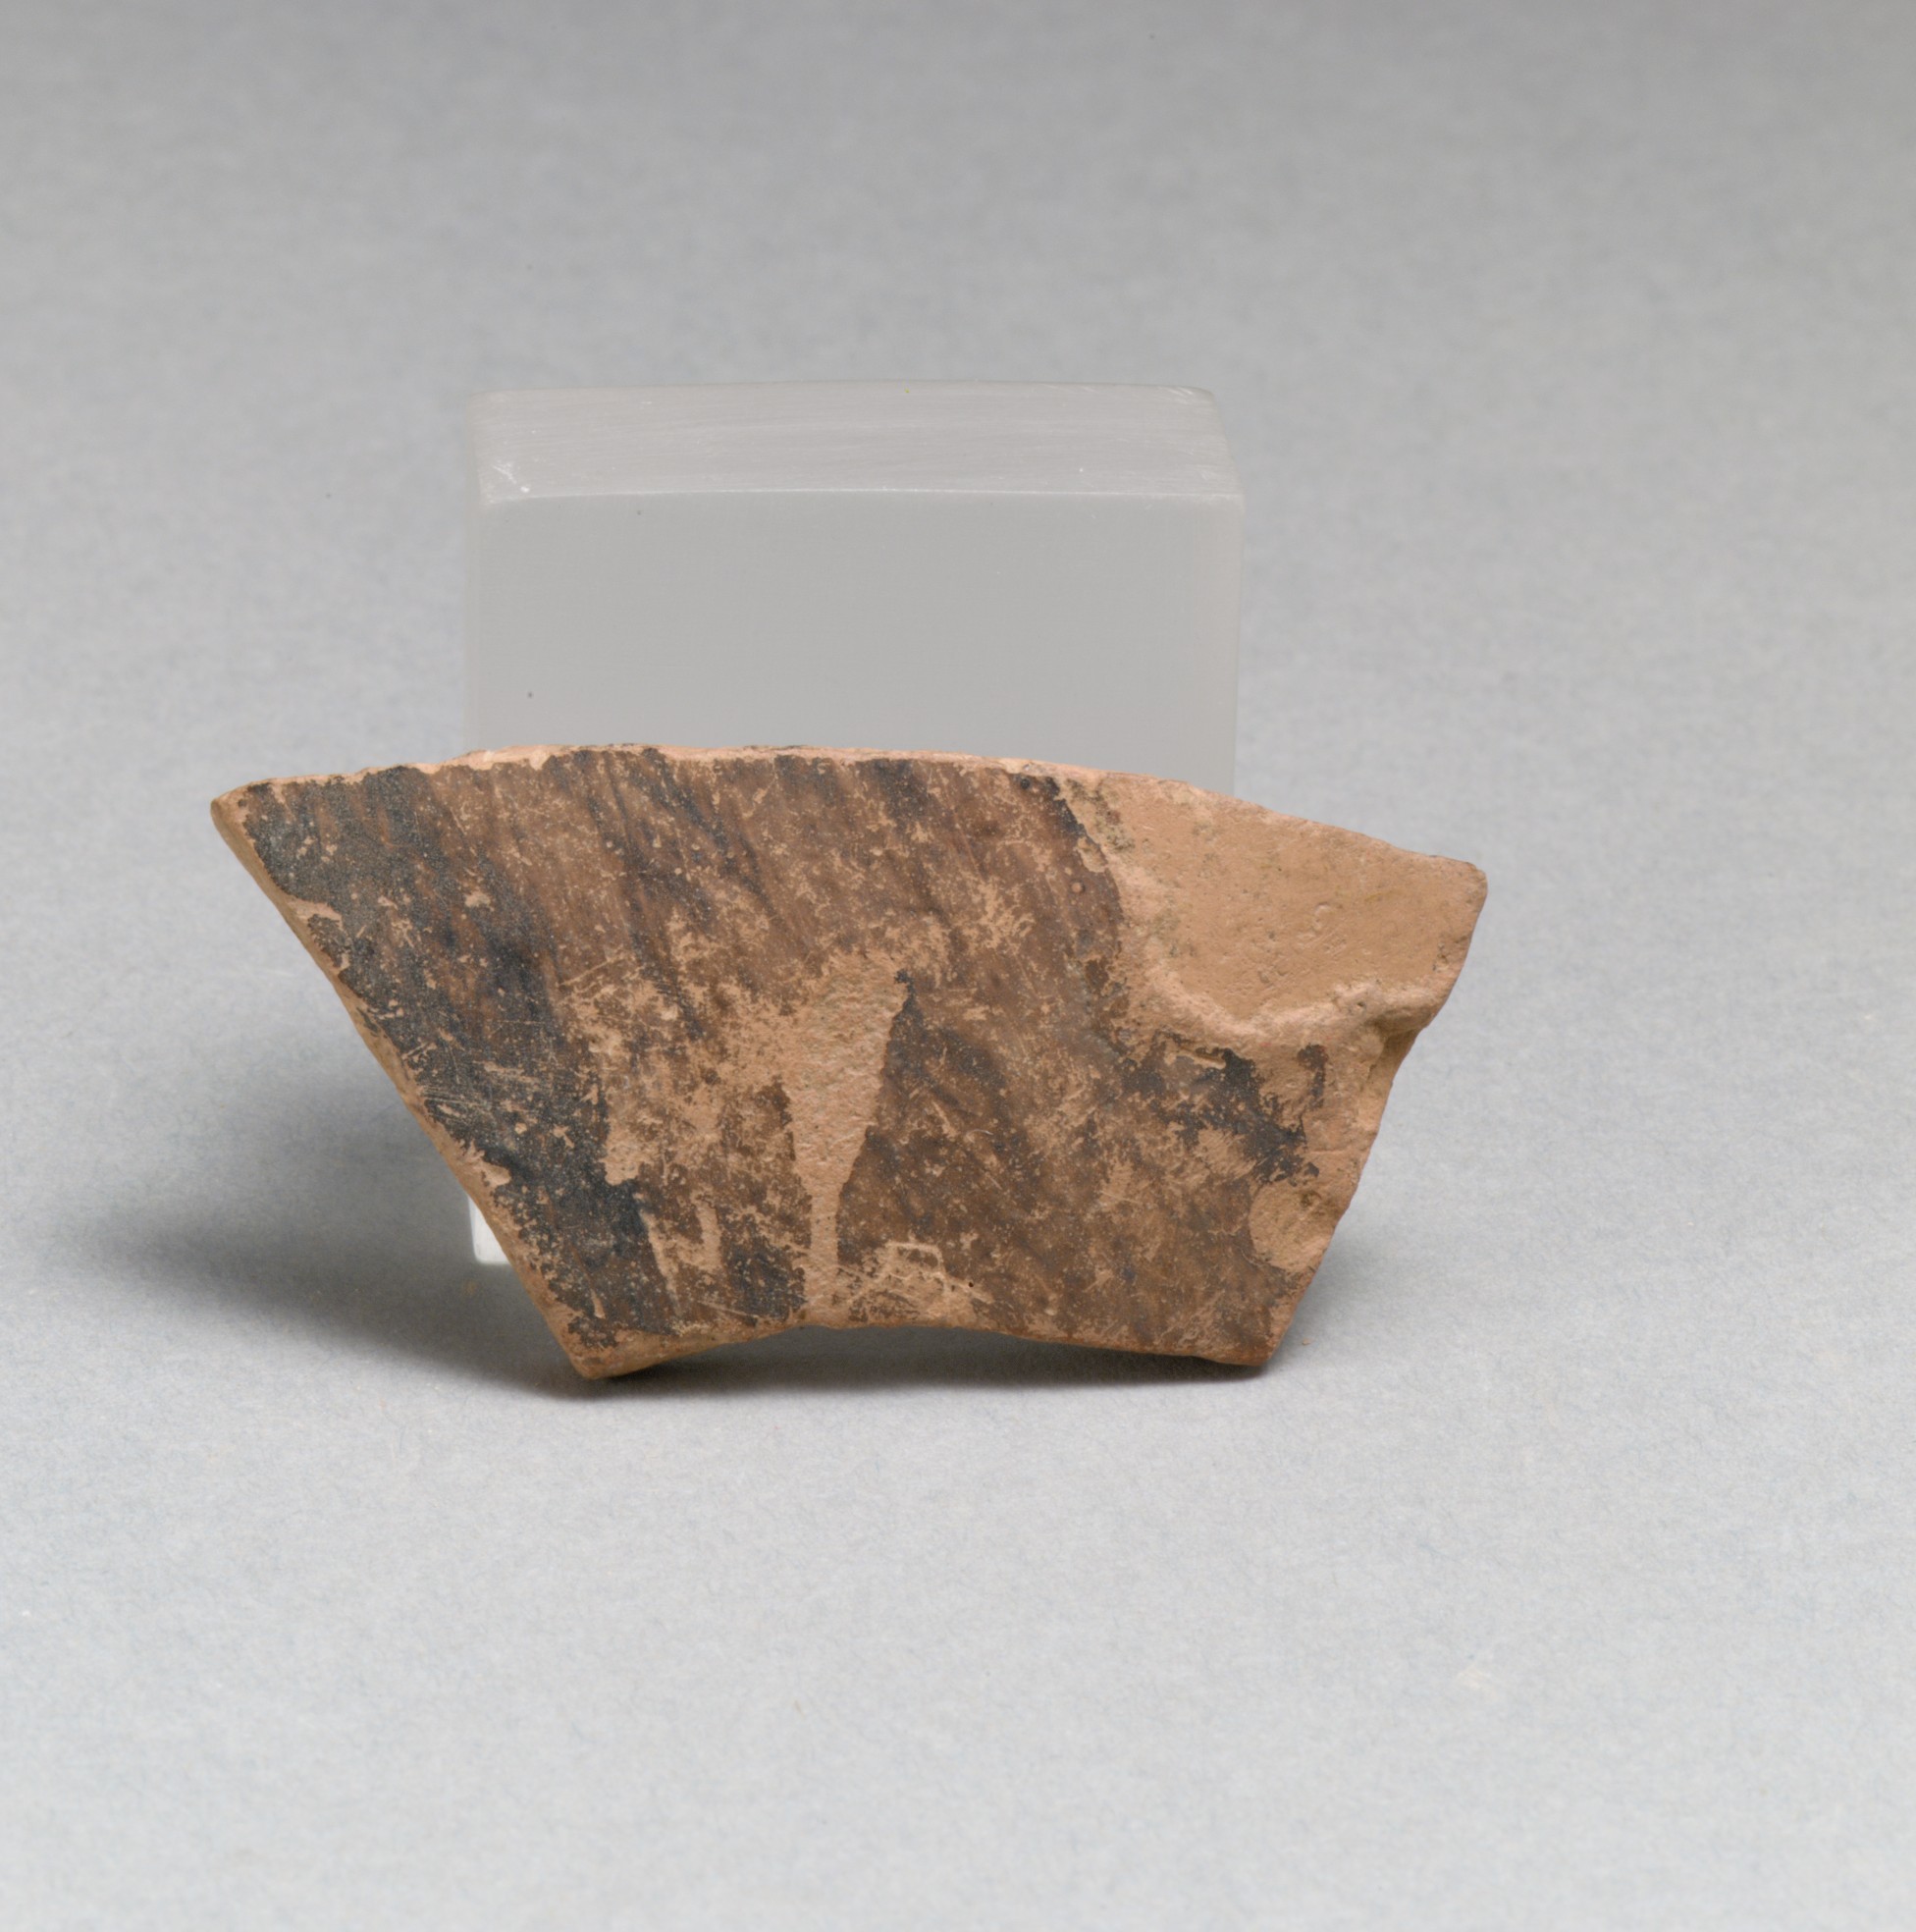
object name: vase fragment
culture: neolithic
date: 7000-3000 BCE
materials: terracotta